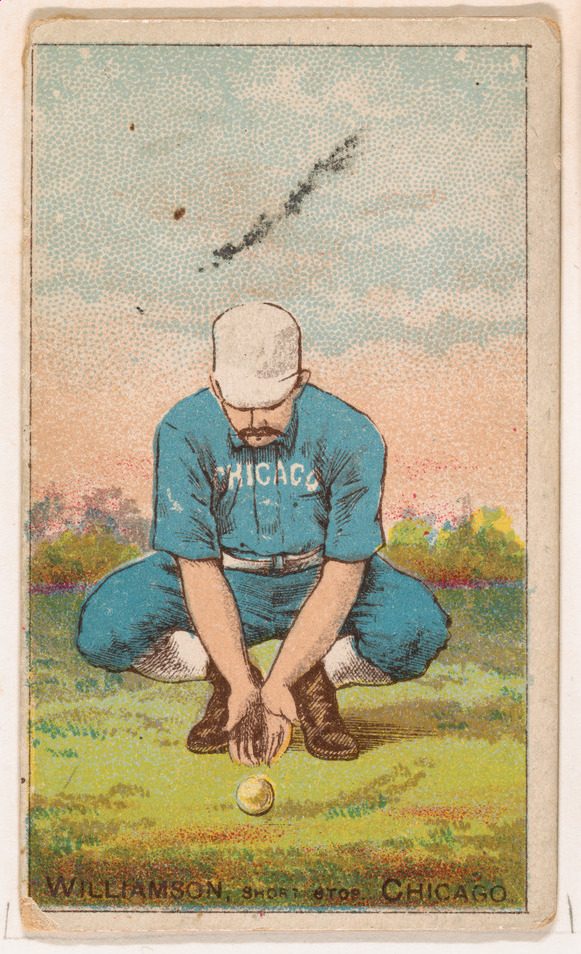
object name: baseball card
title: Williamson, (Fielding Grounder), Shortstop, Chicago, from the Gold Coin series (N284) for Gold Coin Chewing Tobacco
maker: d. buchner & co., new york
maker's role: publisher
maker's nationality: american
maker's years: 1850-1900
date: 1887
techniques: color lithograph, drawing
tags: men,baseball,athletes